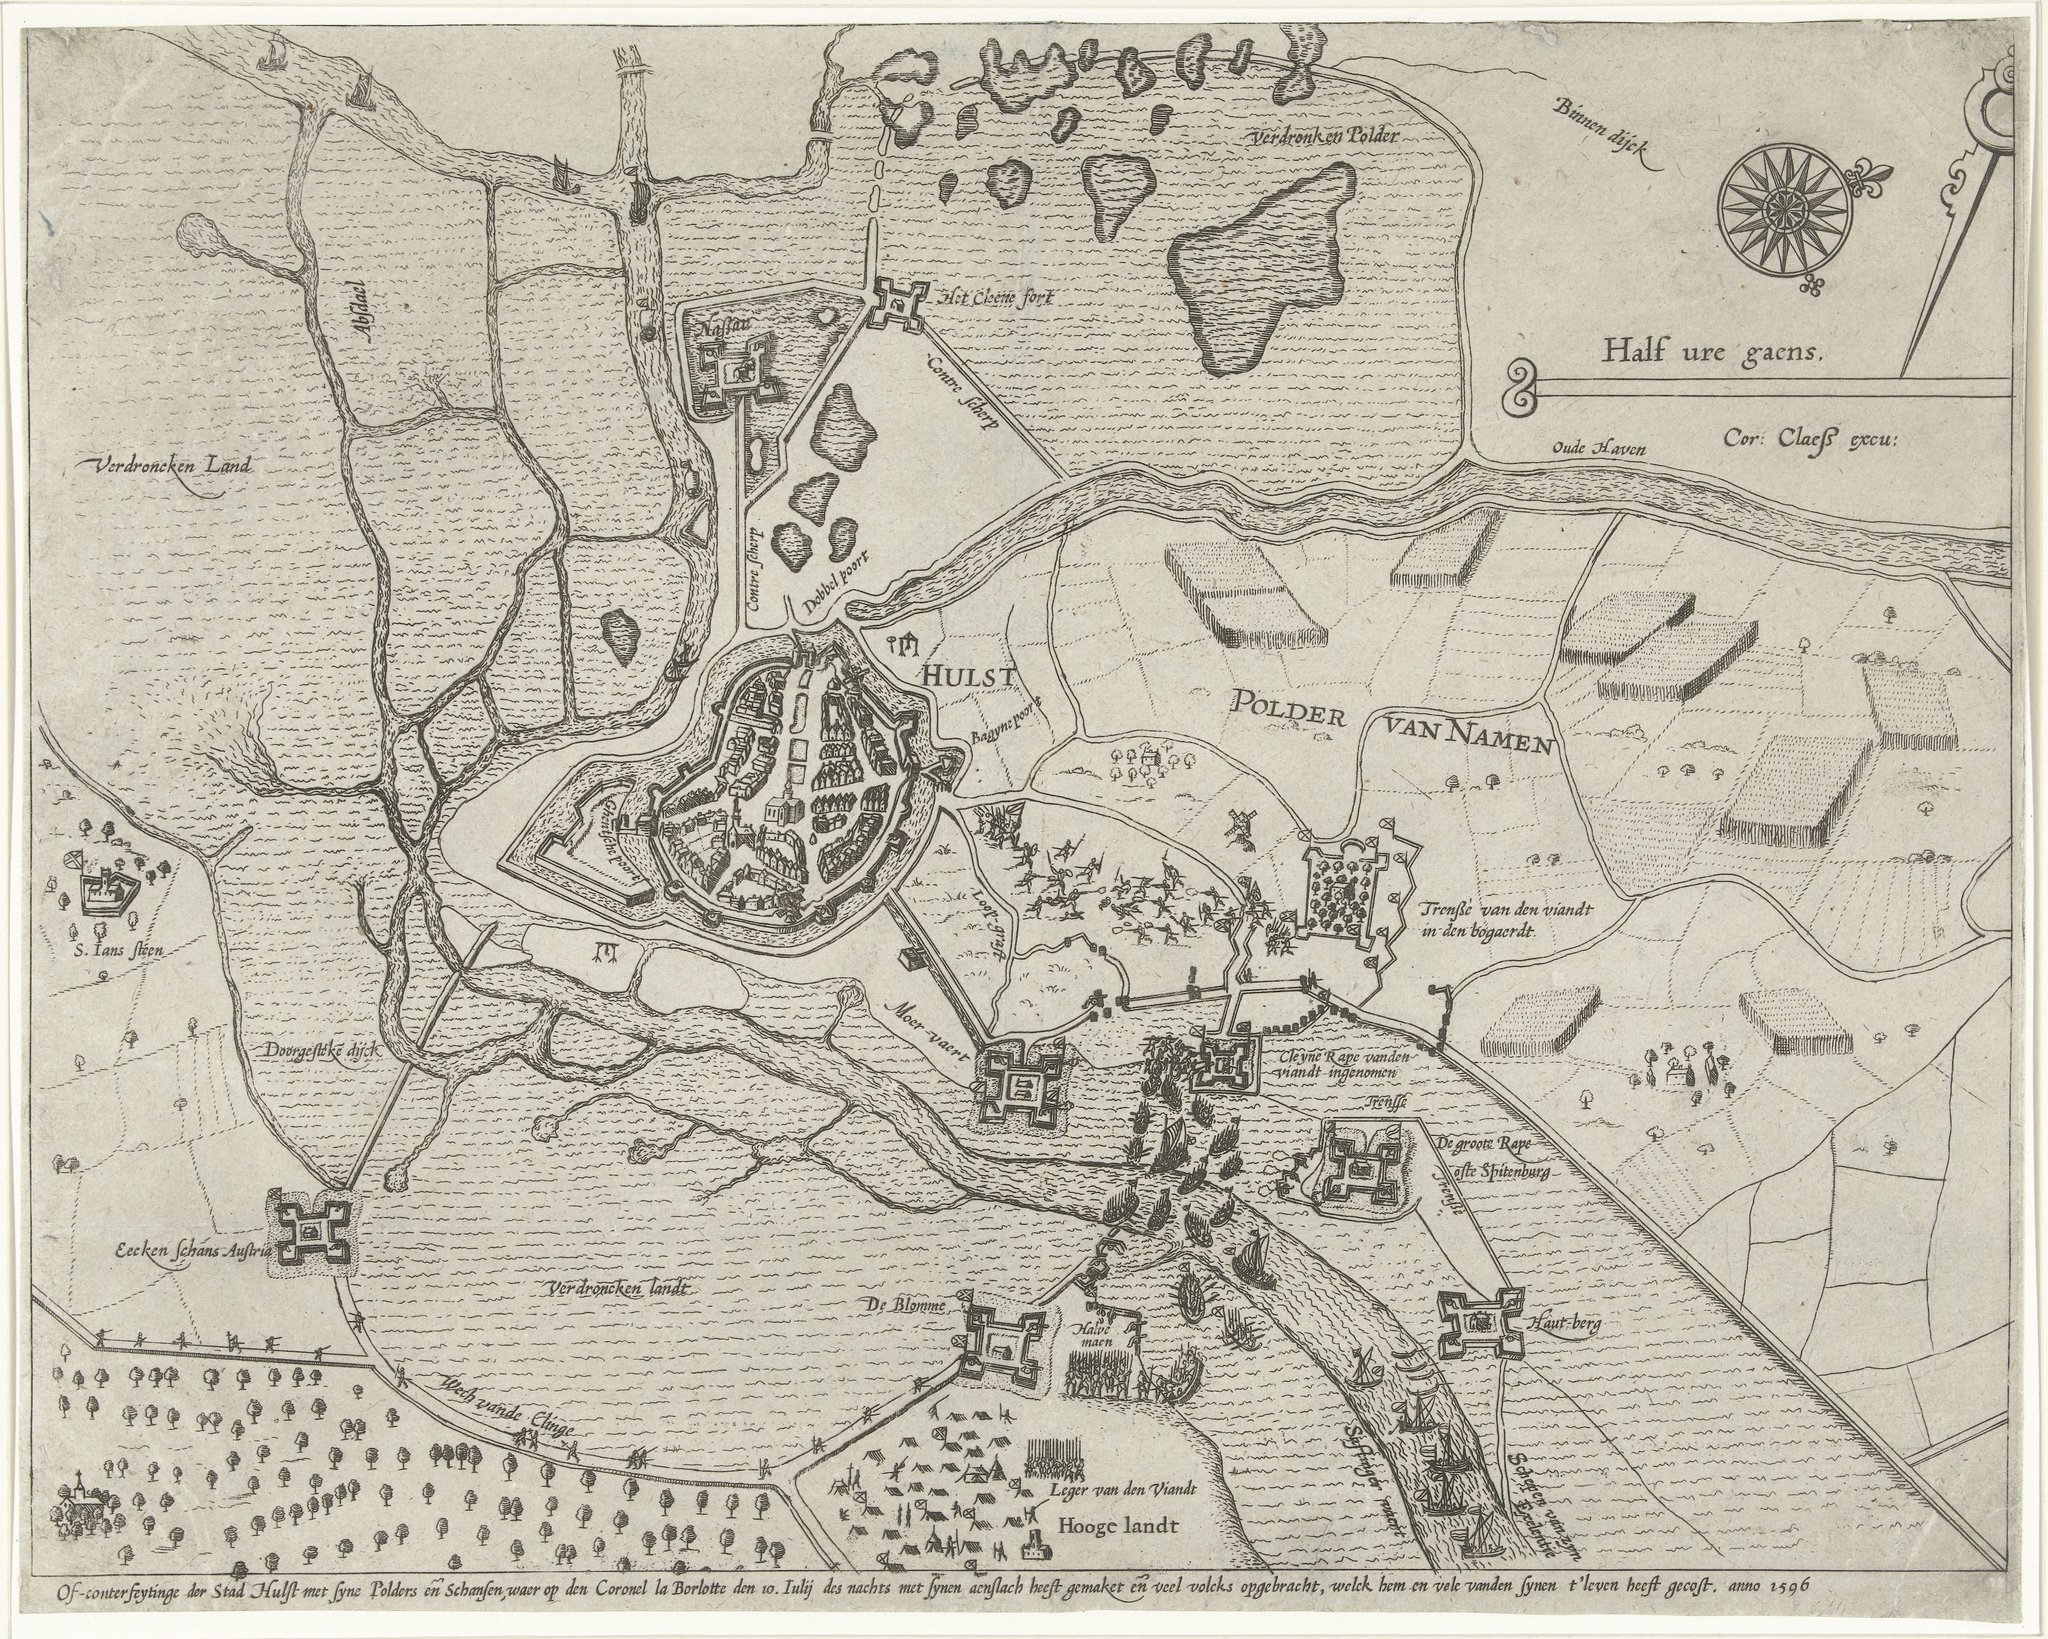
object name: print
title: Of-conterfeytinge der Stad Hulst met syne Polders en[de] Schansen, waer op den Coronel la Borlotte den 10. Iulij des nachts met synen aenslach heeft gemaket en[de] veel volcks opgebracht, welck hem en vele vanden synen t'leven heeft gecost, anno 1596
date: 1596-1598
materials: paper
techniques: etching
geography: low countries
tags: brussels, albrecht aartshertog van oostenrijk, siege, position war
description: Beleg van Hulst door het Spaanse leger onder aartshertog Albrecht van Oostenrijk, eerste fase 8 juli - 11 juli 1596. Plan van Hulst met omringende schansen, polders en verdronken land. Onderaan het Spaanse kamp van waaruit de vaart is overgestoken om schansen in handen van het Staatse leger aan te vallen. Rechtsboven een windroos en passer voor de schaal. Alle opschriften in de plaat in het Nederlands.